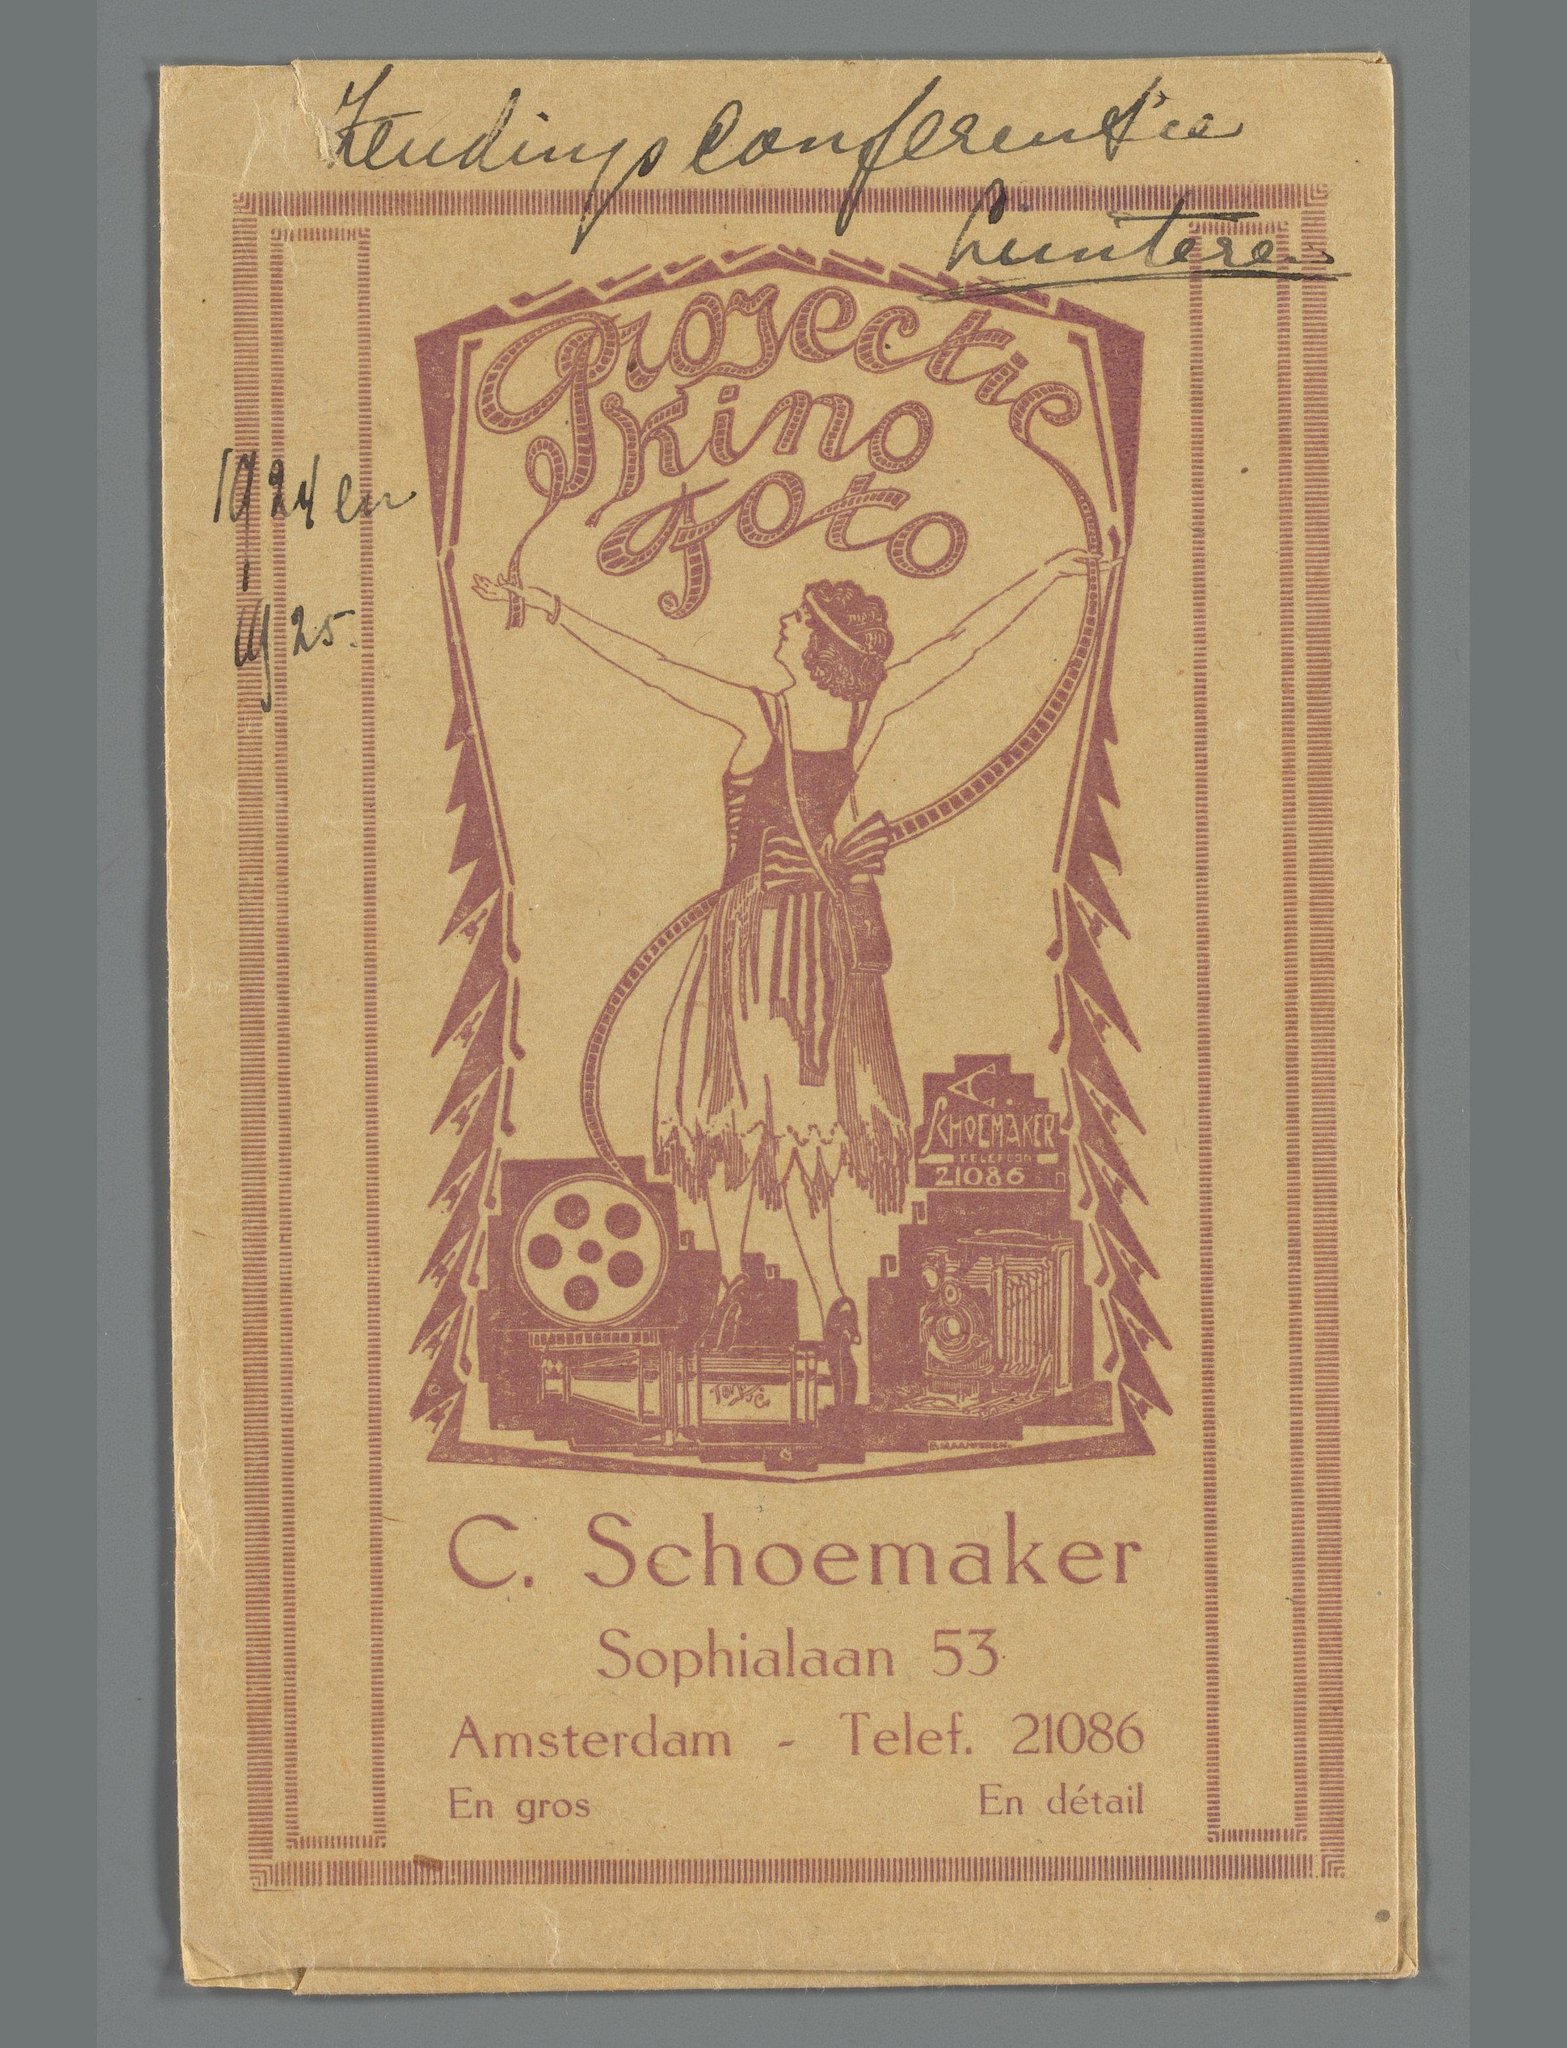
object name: photomap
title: Projectie Kino Foto C. Schoemaker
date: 1925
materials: paper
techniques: letterpress printing, engraving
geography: amsterdam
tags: camera ~ photography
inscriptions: inscription: ‘Zendingsconferentie/ Lunteren/ 1924 en/ 1925’